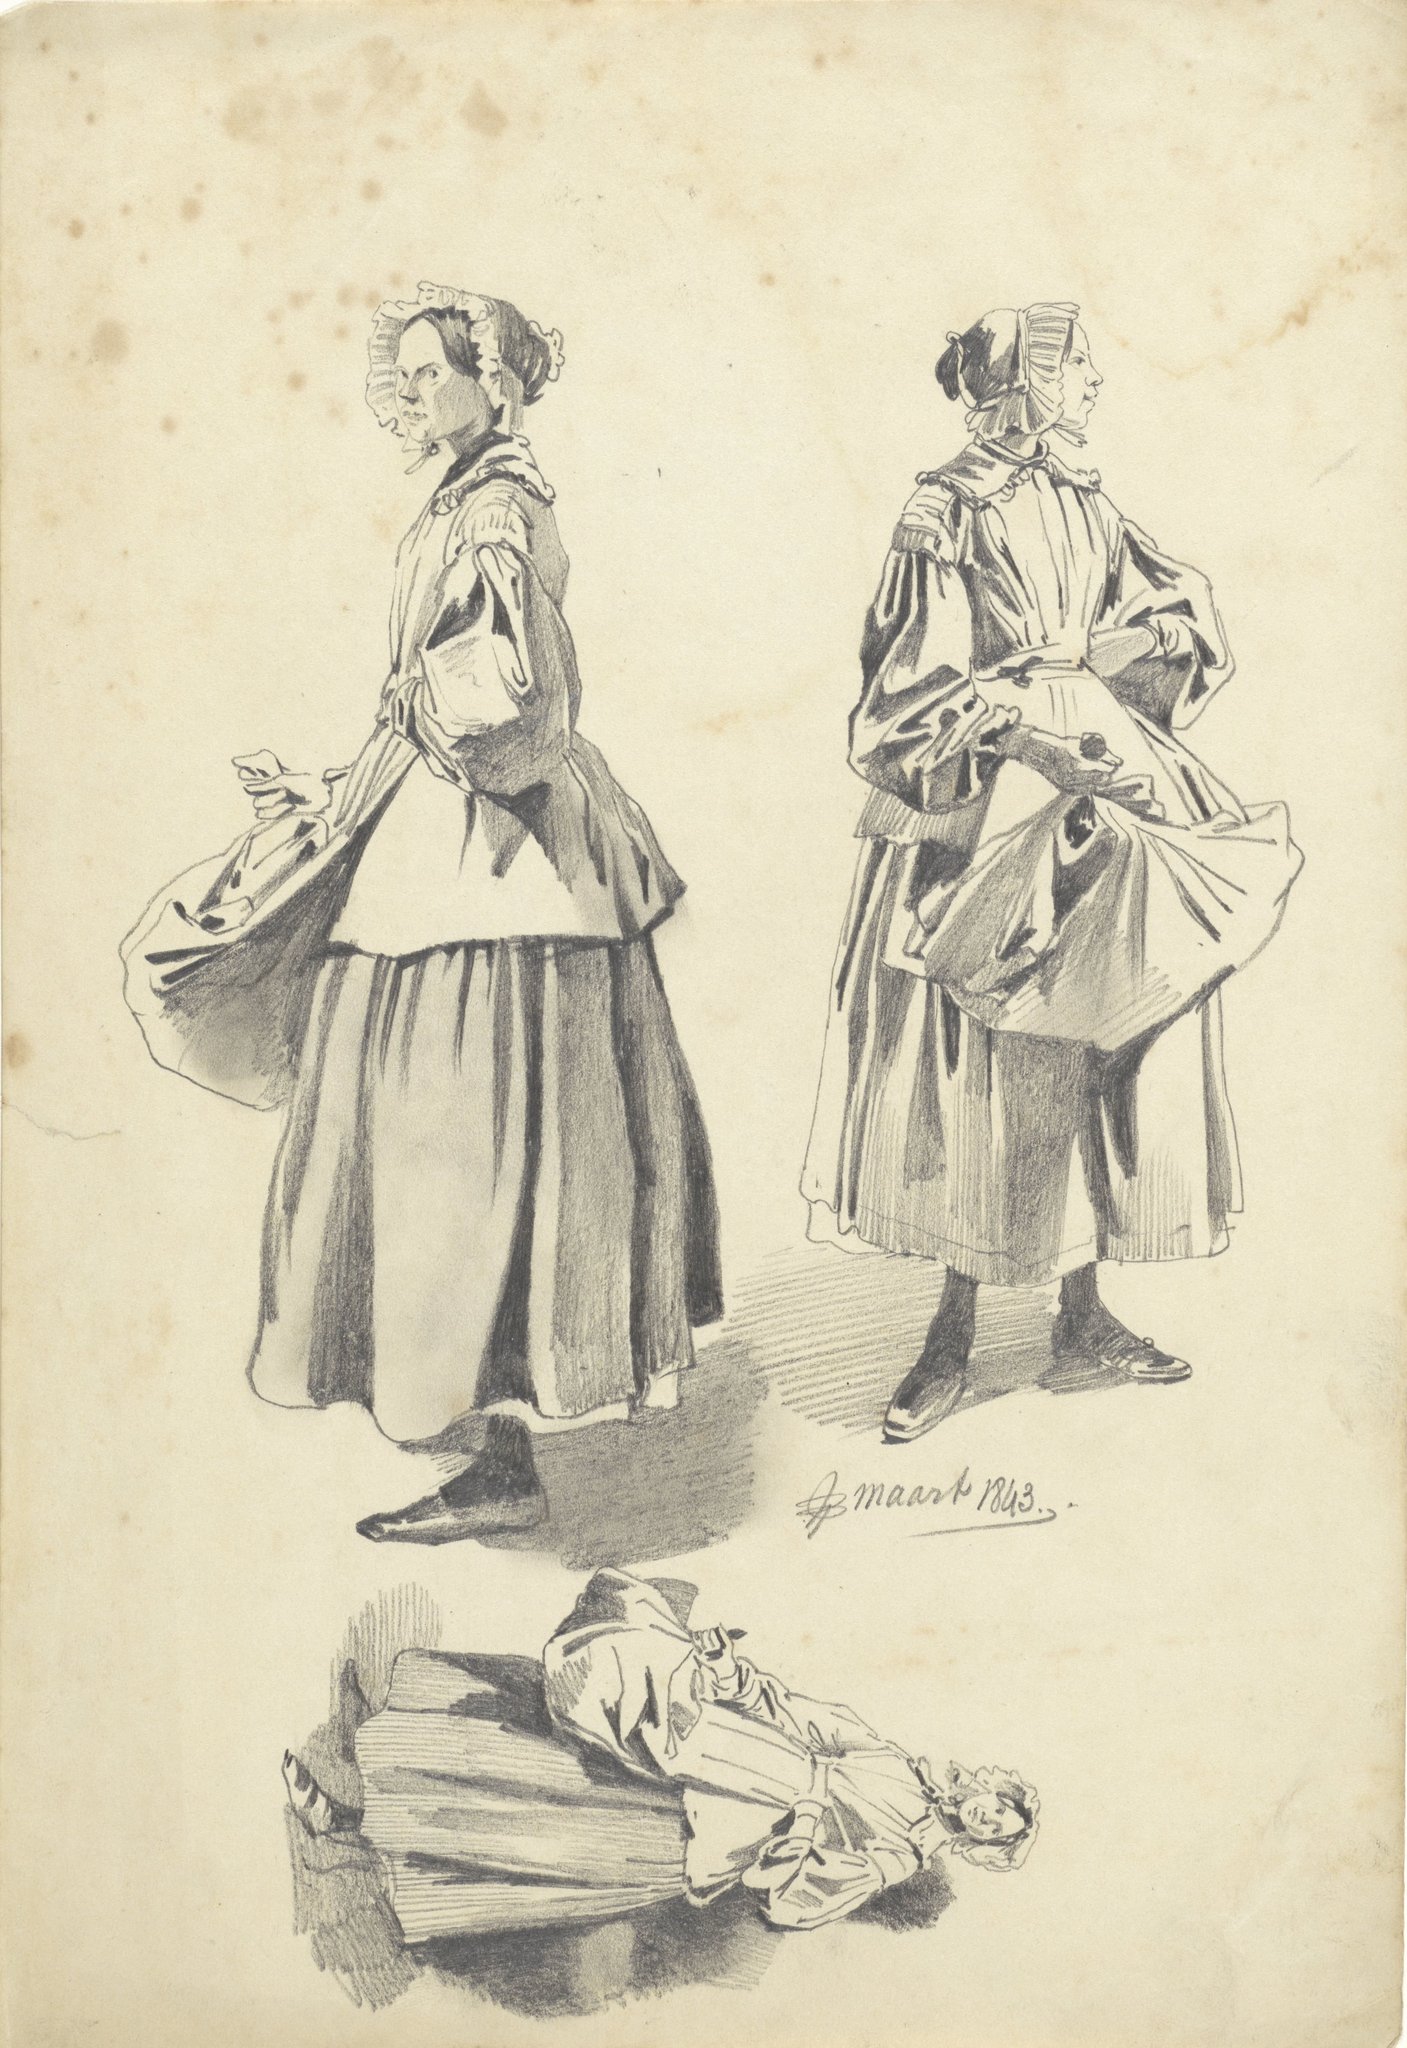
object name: drawing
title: Drie studies van een staande vrouw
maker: pieter van loon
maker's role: draughtsman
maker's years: 1801-1873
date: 1803-1843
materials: paper, pencil